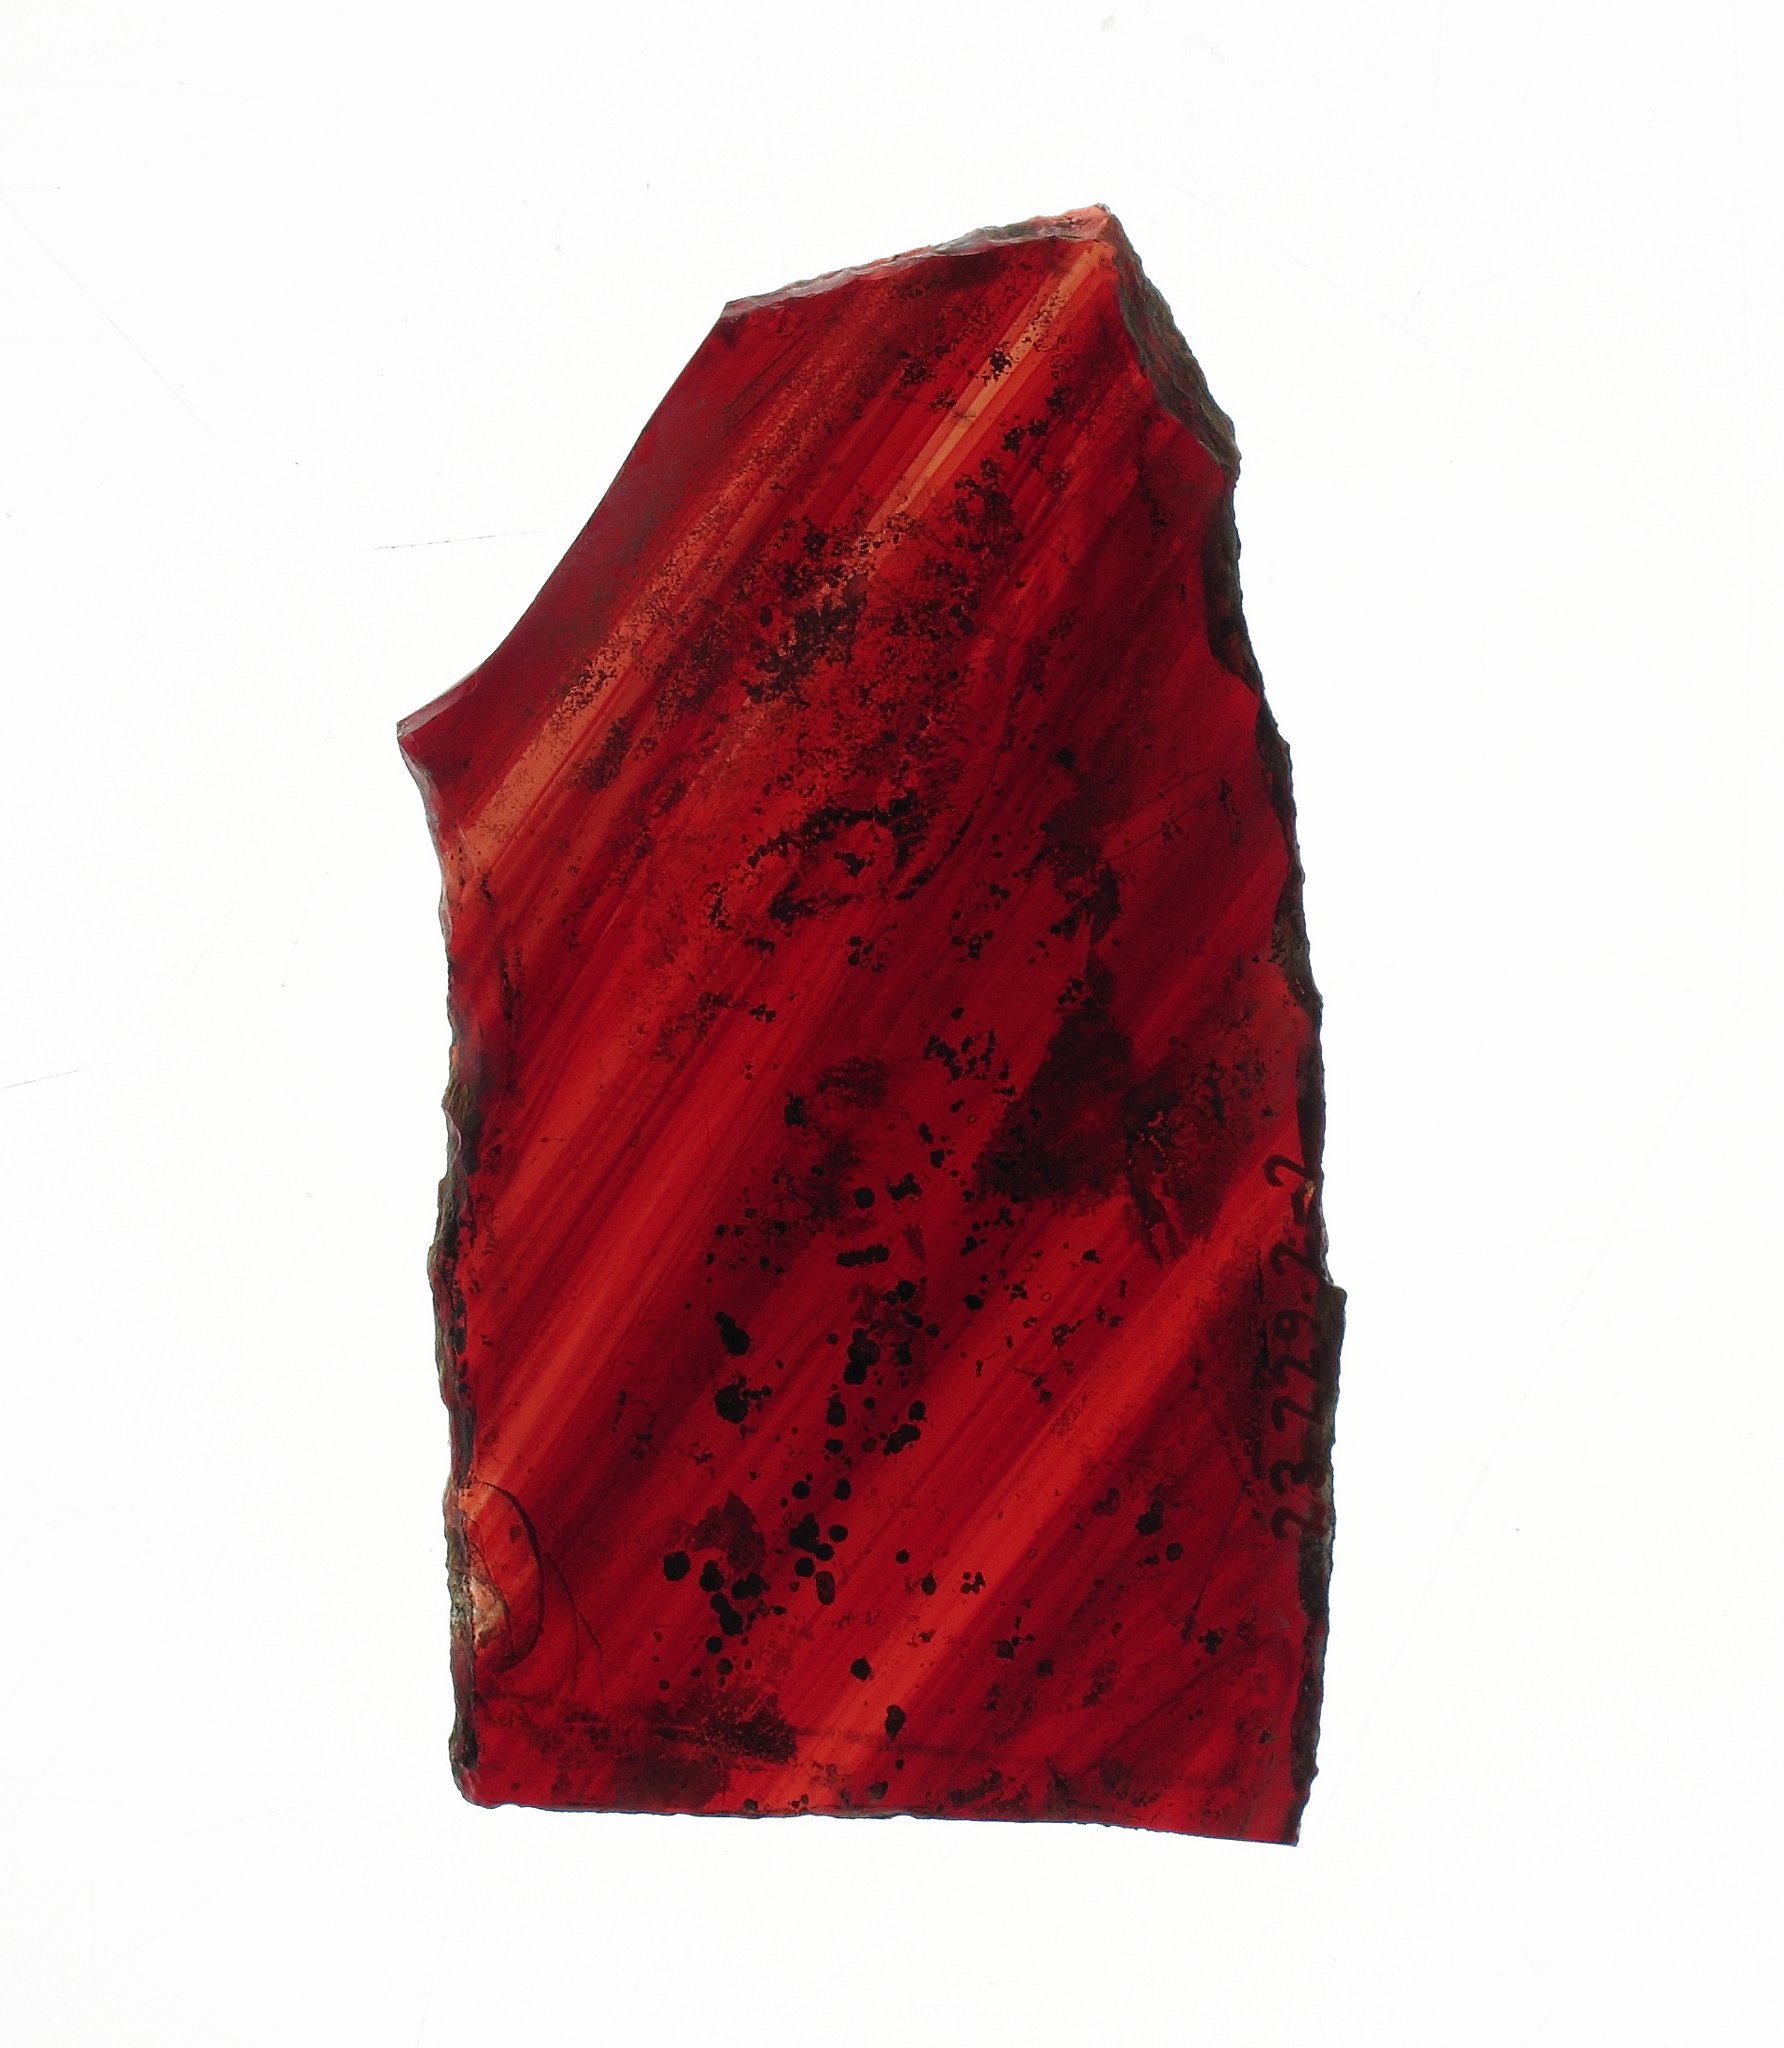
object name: fragment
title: Glass Fragment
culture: french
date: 1101-1300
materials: glass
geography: france